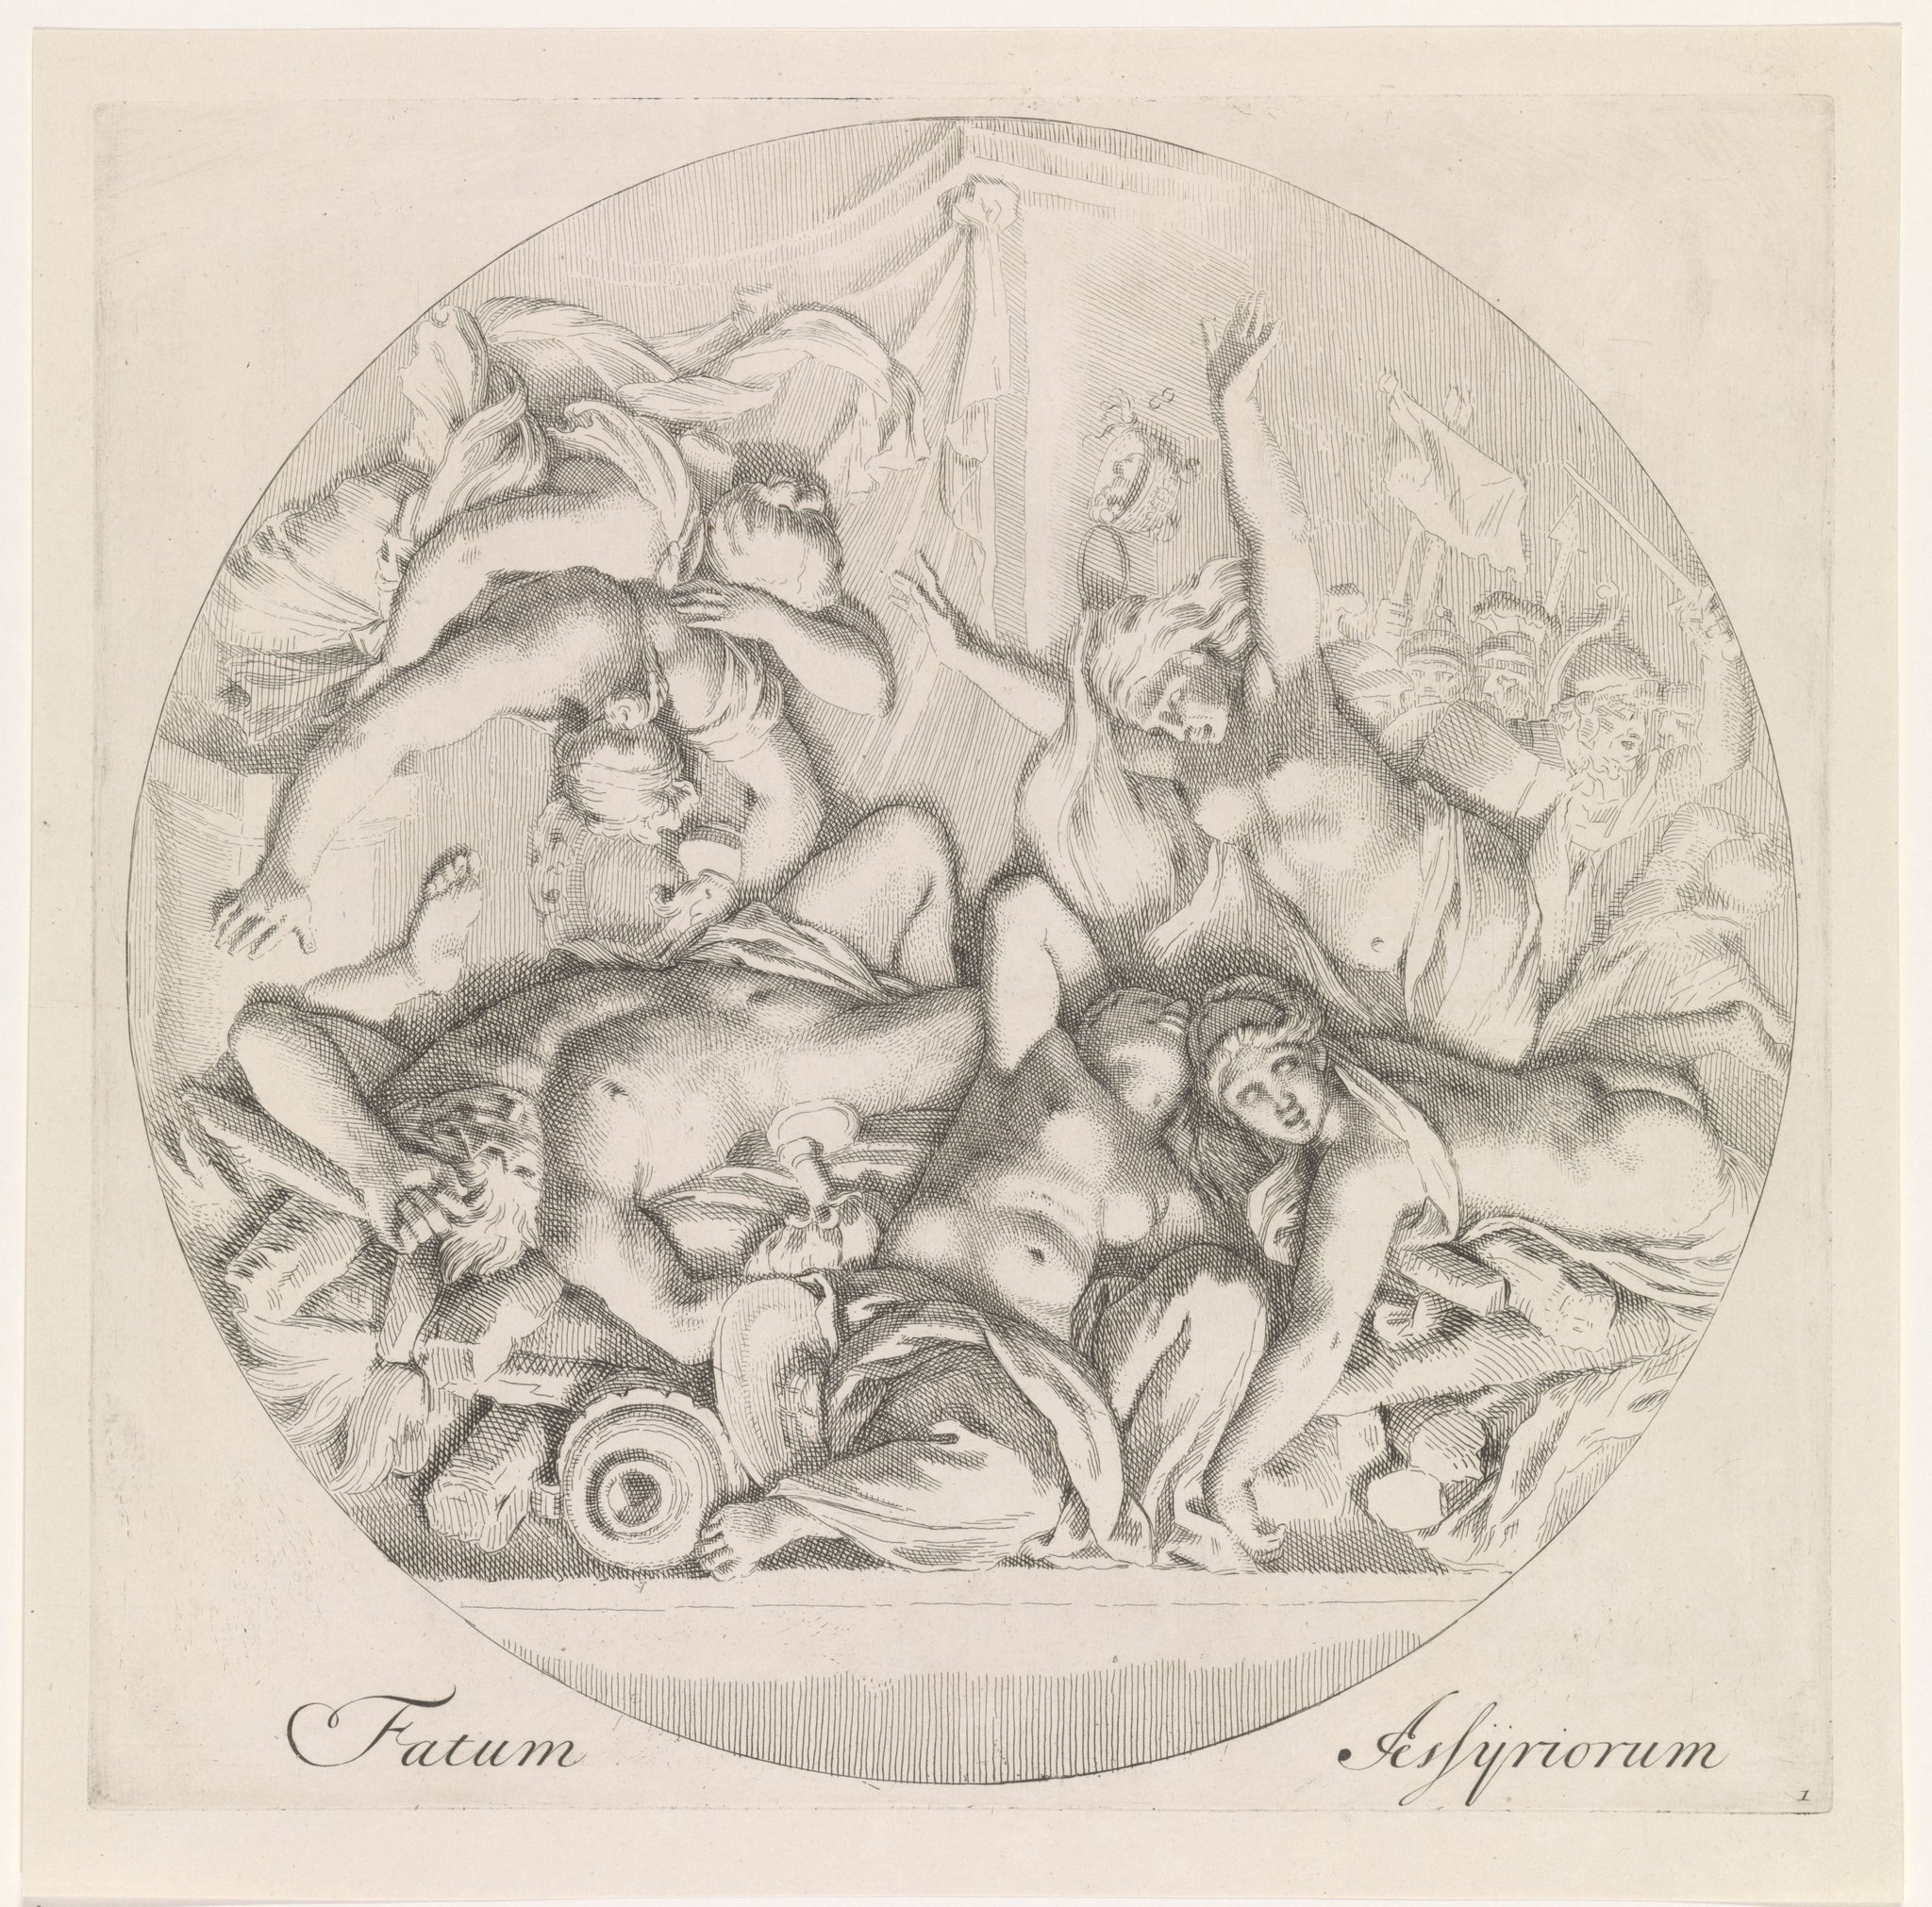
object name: print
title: Dood van Sardanapalus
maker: johannes glauber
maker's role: draughtsman, painter, print maker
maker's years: 1646-1726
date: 1684-1726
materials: paper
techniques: etching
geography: amsterdam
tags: death of sardanapalus: before burning himself in his palace with all his treasures, he has his harem and his horses killed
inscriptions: collector's mark: Lugt 2228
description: Ronde voorstelling. De Assyrische koning Sardanapalus steekt zijn paleis in brand nadat de Meden zijn leger hebben verslaan bij Nineve. Hij jaagt zijn hofhouding om de kling. De prent is naar een verloren bas-reliëf van Gerard de Lairesse en maakt deel uit van een vierdelige serie met als onderwerp de ondergang van wereldrijken in de klassieke oudheid.